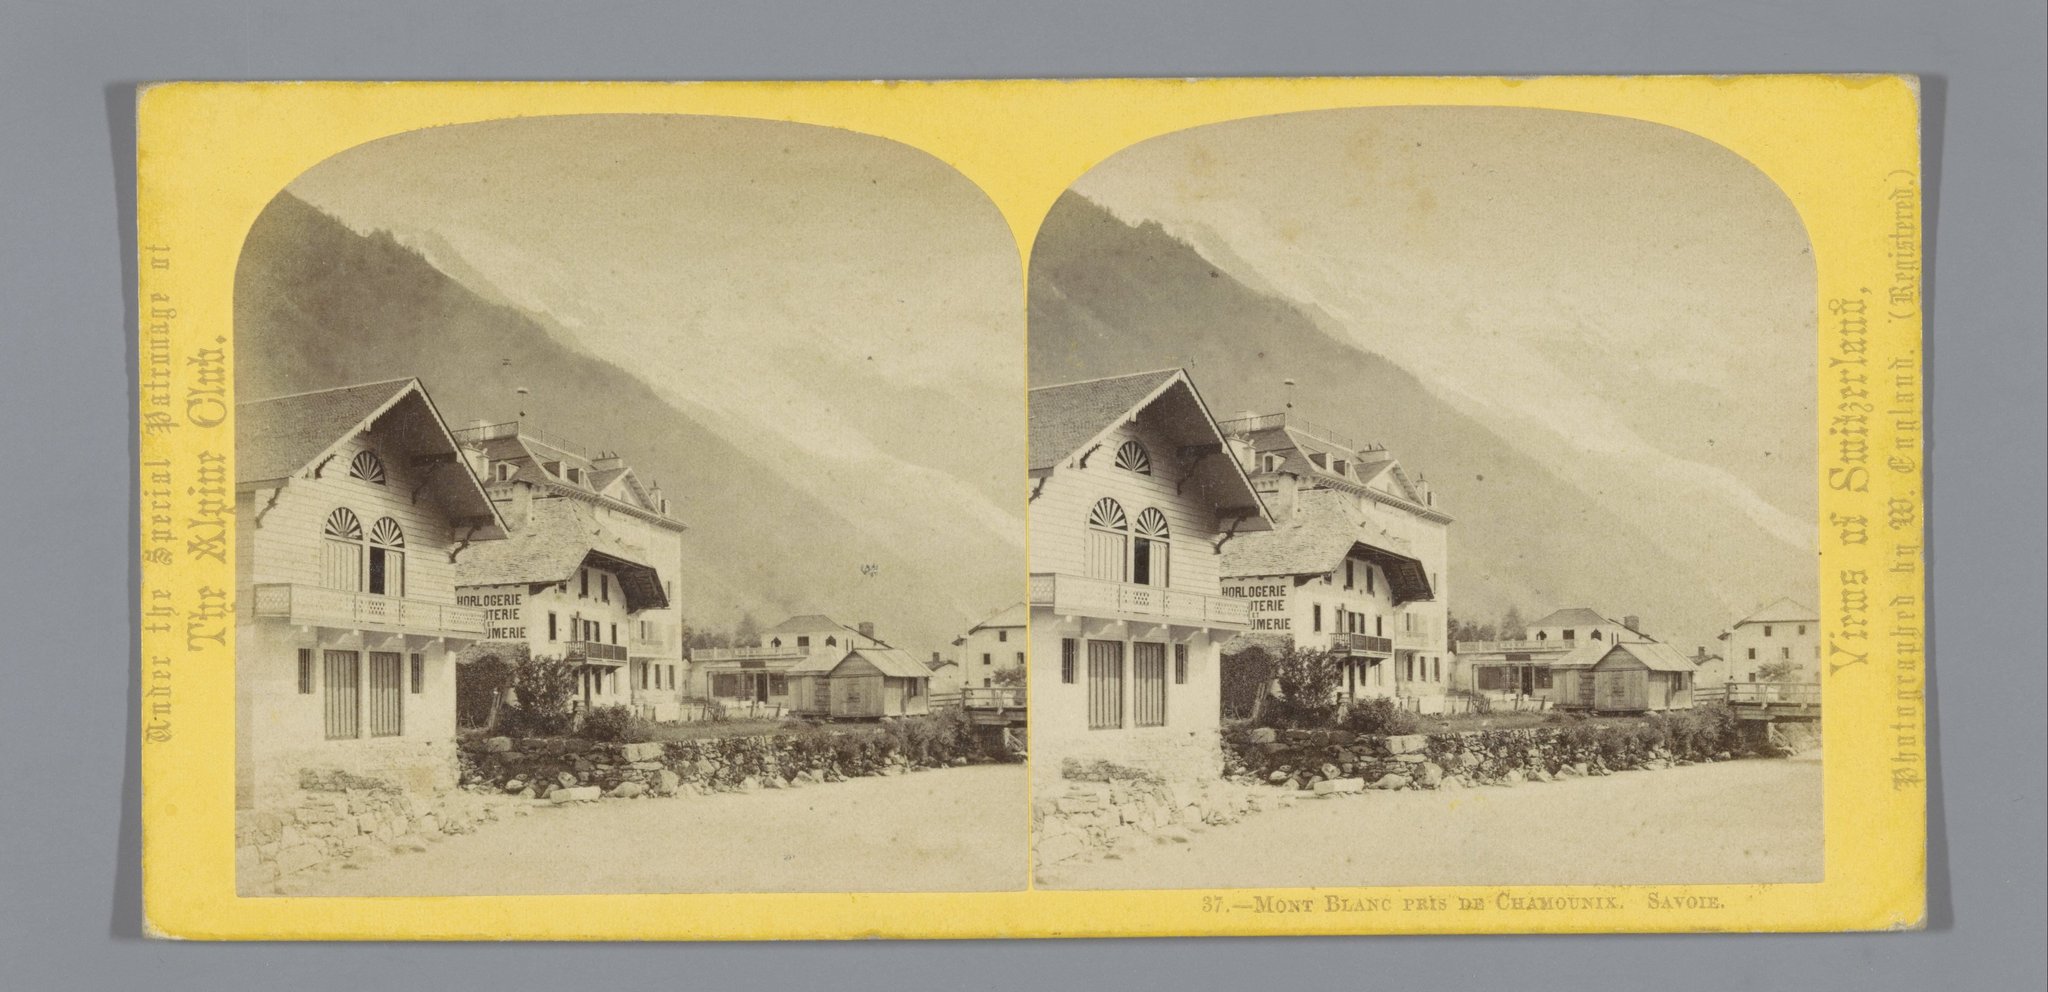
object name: stereograph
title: Gebouwen te Chamonix, met op de achtergrond de Mont Blanc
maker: william england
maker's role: fotograaf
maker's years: 1816-1896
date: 1850-1880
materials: cardboard, photographic support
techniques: albumen print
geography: chamonix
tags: dale, valley, façade (of house or building), mountains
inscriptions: number: ‘37.’, inscription: ‘Views of Switzerland, photographed by W. England. (Registered) Under the Special Patronage of the Alpine Club.’